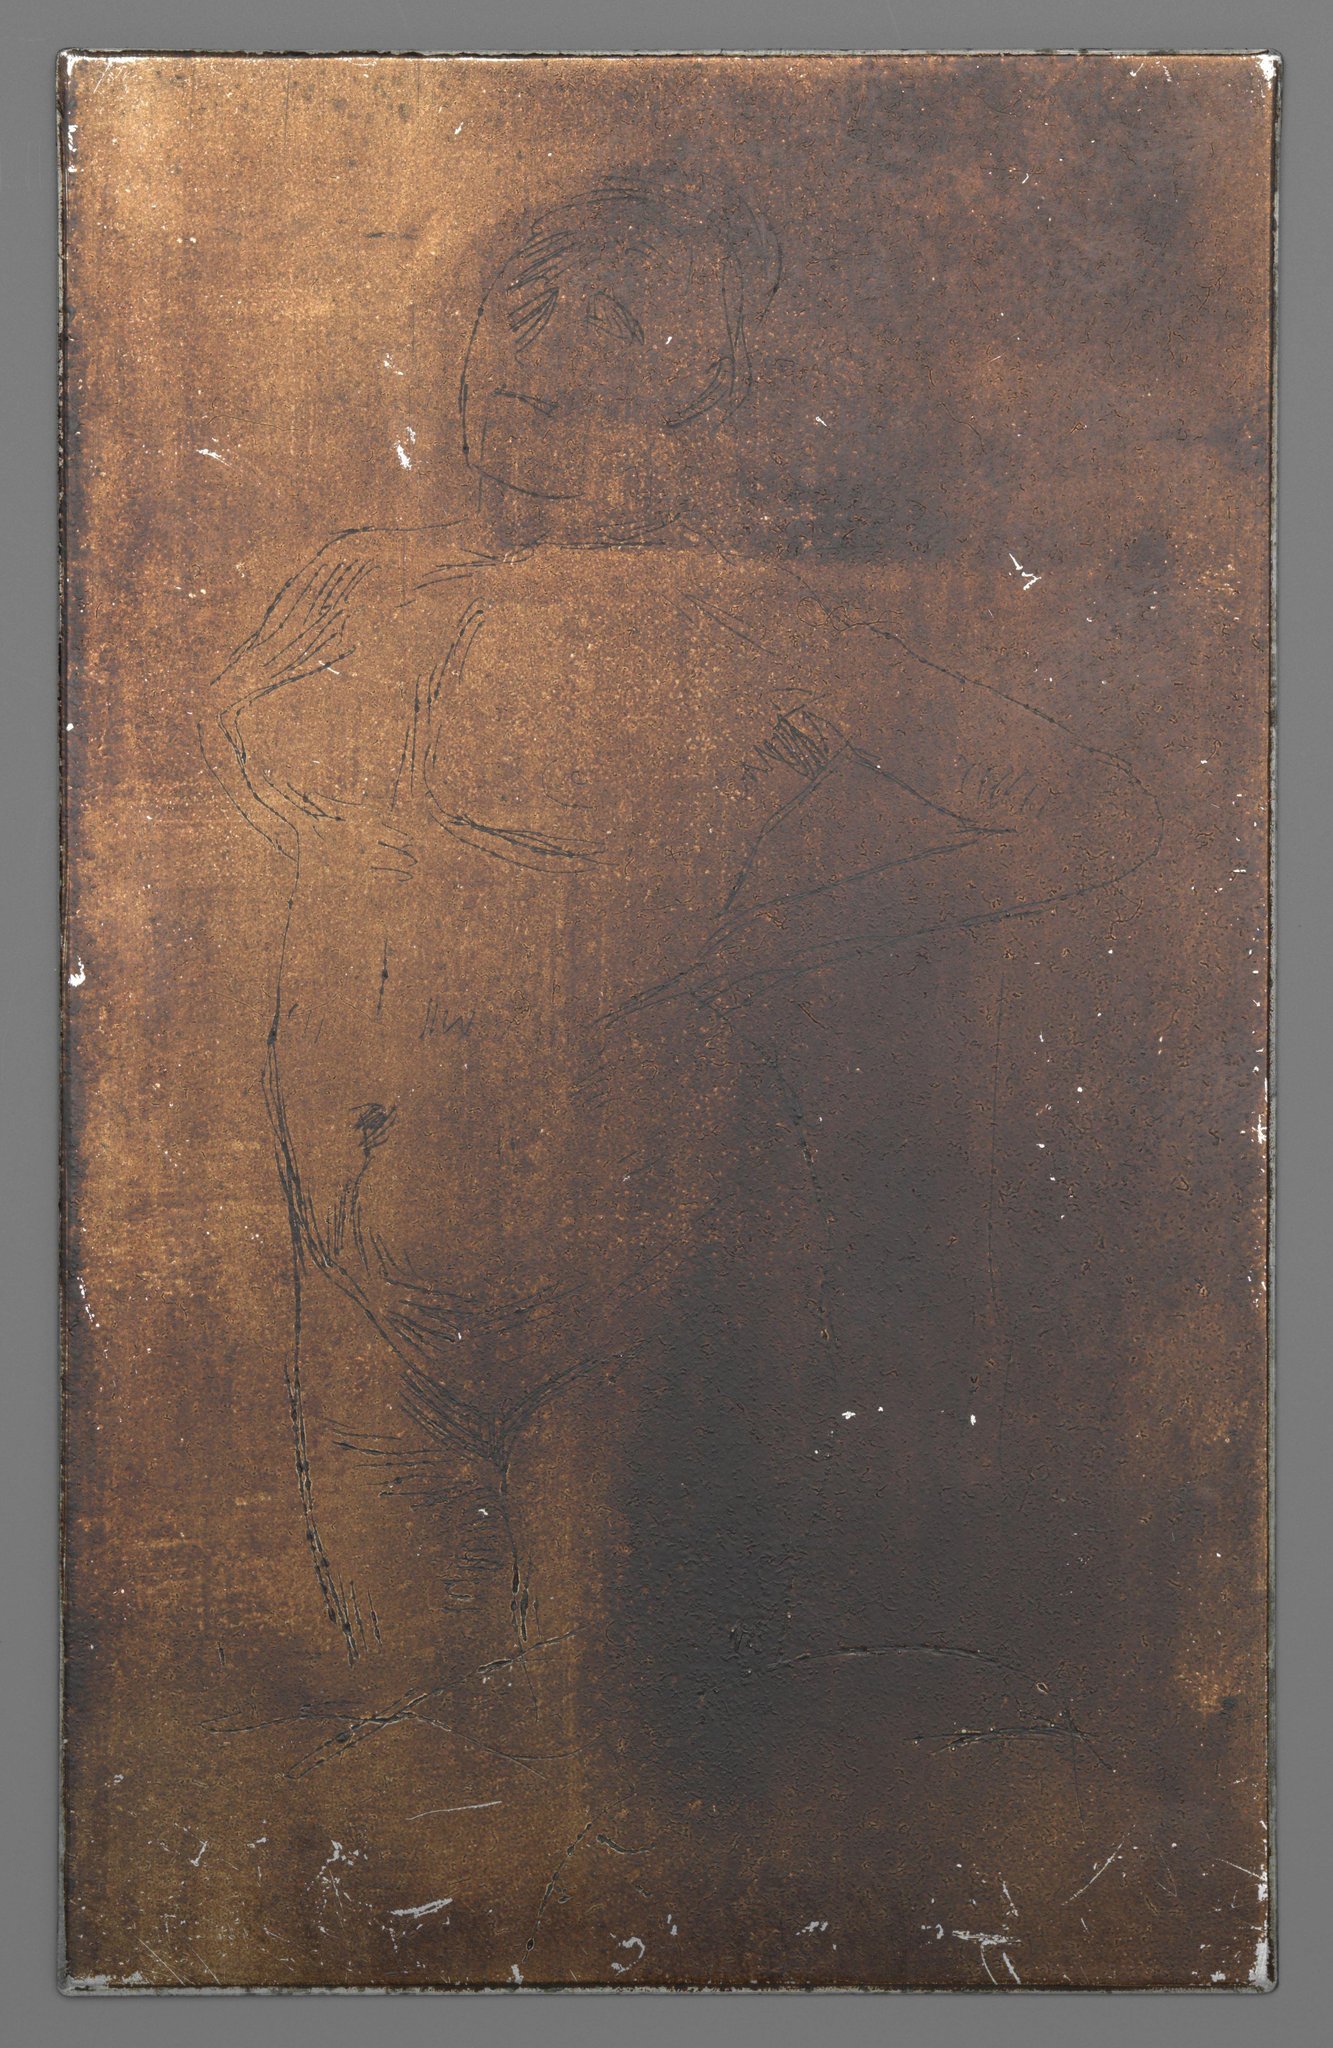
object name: zinkplaat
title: Staande, naakte vrouw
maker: george hendrik breitner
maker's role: draughtsman, painter, print maker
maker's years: 1857-1923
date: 1891-1893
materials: zinc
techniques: etching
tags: woman (showing herself) undressed, quasi-nude